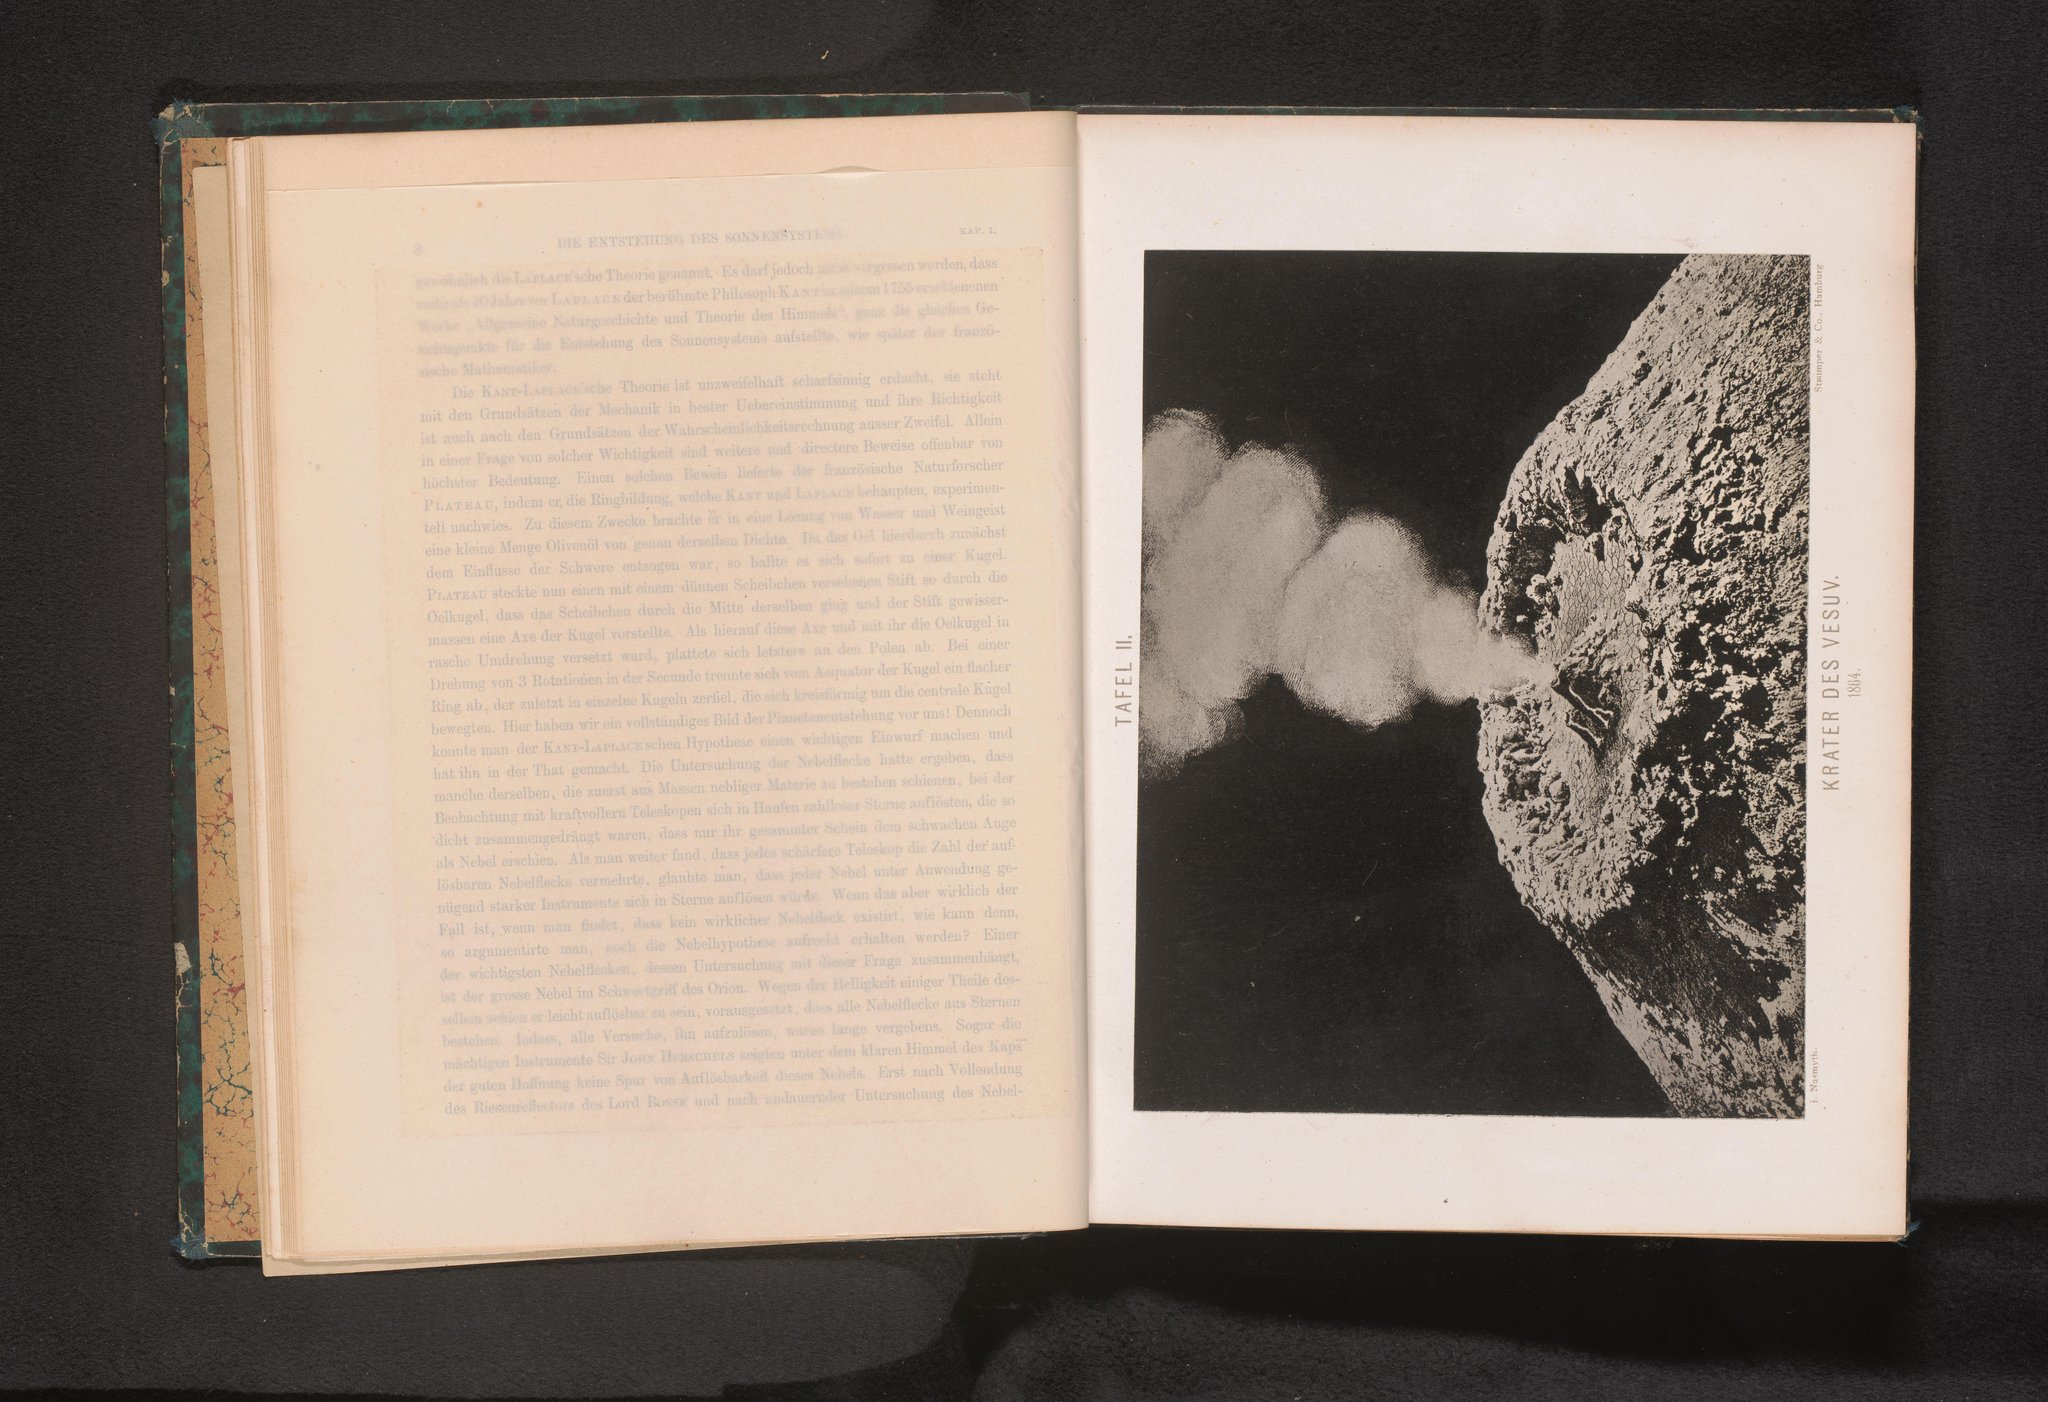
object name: photomechanical print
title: Krater des Vesuv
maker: james nasmyth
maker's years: 1808-1890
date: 1864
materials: paper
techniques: photograph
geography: hamburg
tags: volcano, mount vesuvius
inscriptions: number: ‘Tafel II.’